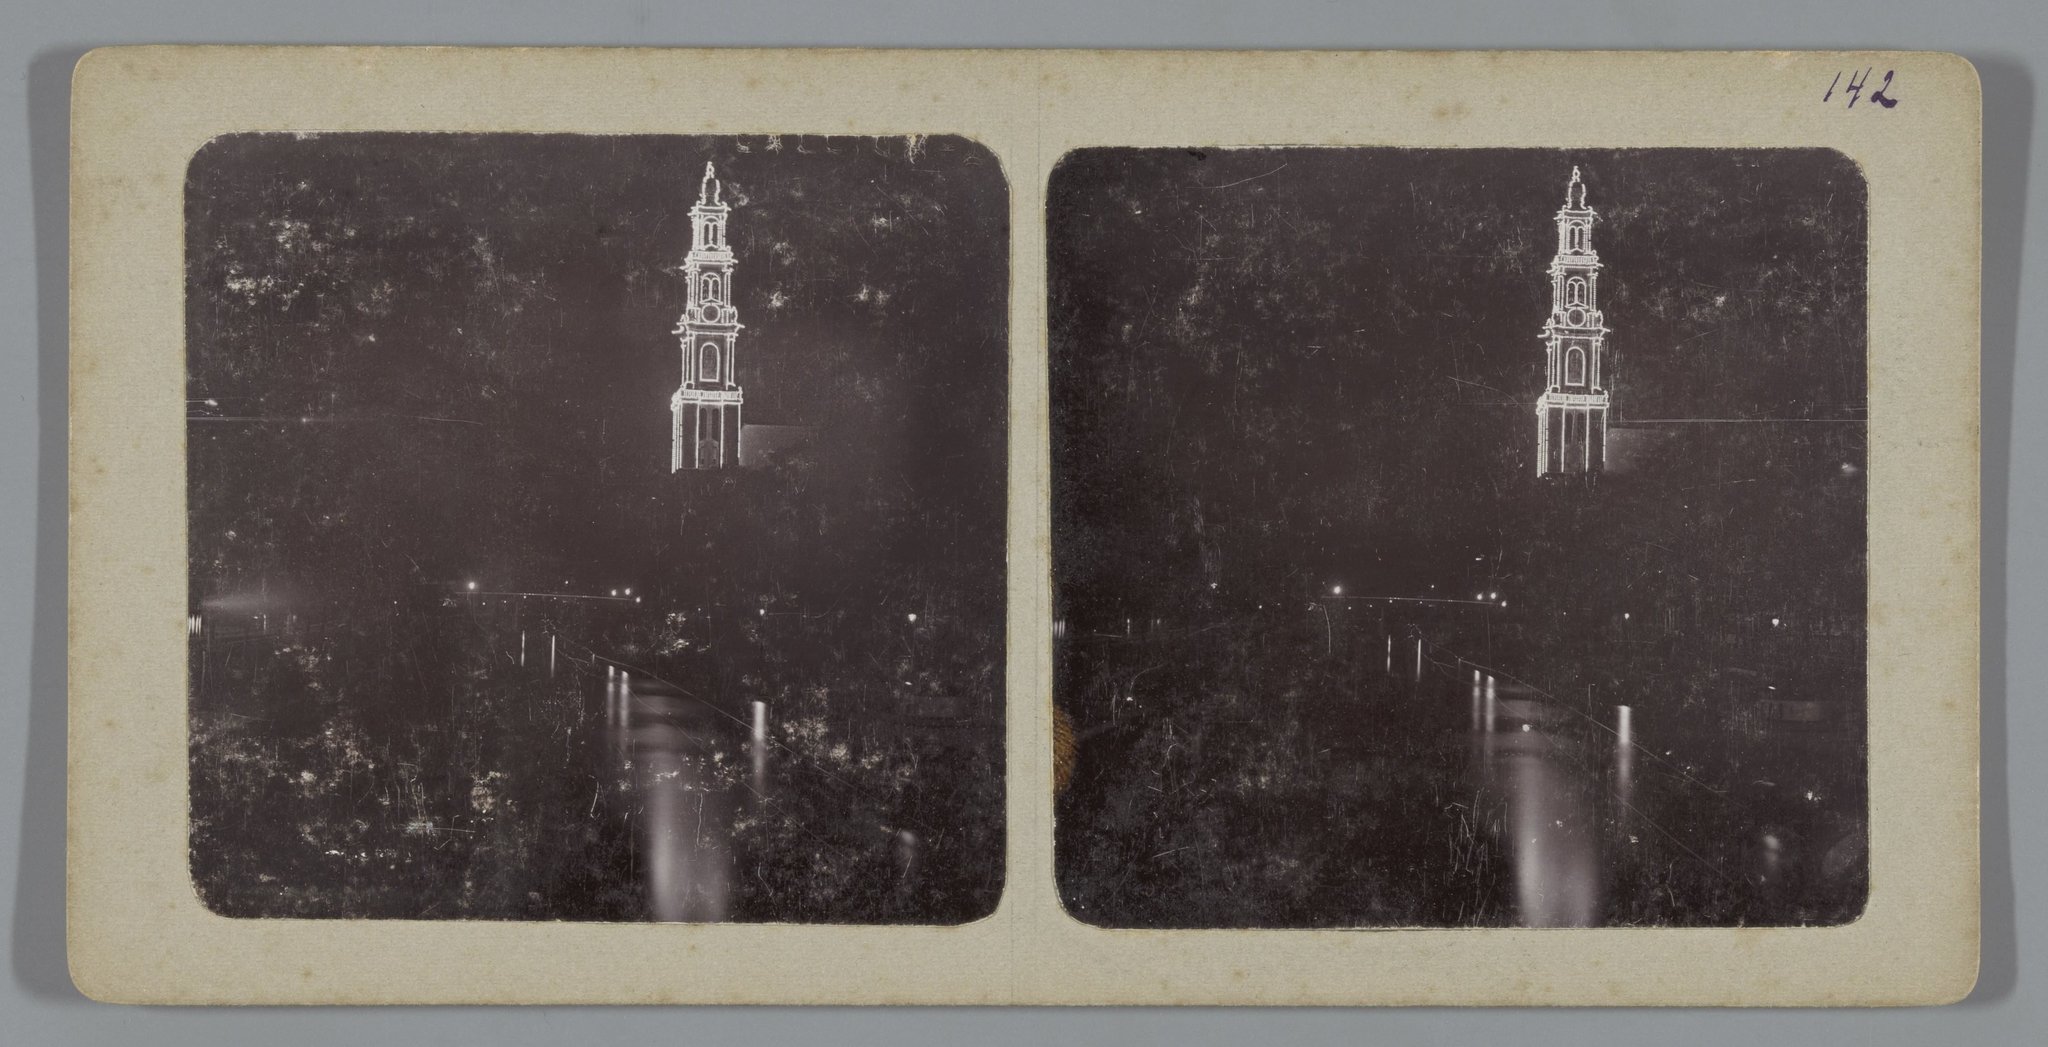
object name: stereograph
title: Verlichte toren van de Westerkerk weerspiegelt in de Prinsengracht, Amsterdam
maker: Anonymous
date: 1910-1938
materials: paper, cardboard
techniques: collodion silver print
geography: amsterdam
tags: artificial light, night, parts of church exterior and annexes: tower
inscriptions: number: ‘142’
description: Er zijn verschillende gelegenheden waarvoor de Westertoren werd verlicht: het bezoek van konigin Wilhelmina (1910), het 25-jarig regeringsjubileum van koningin Wilhelmina (1923), de Olympische Spelen van Amsterdam (1928), de Edison Lichtweek (1929), de Universiteitsfeesten (1932) en het 40-jarig regeringsjubileum van koningin Wilhelmina (1938).